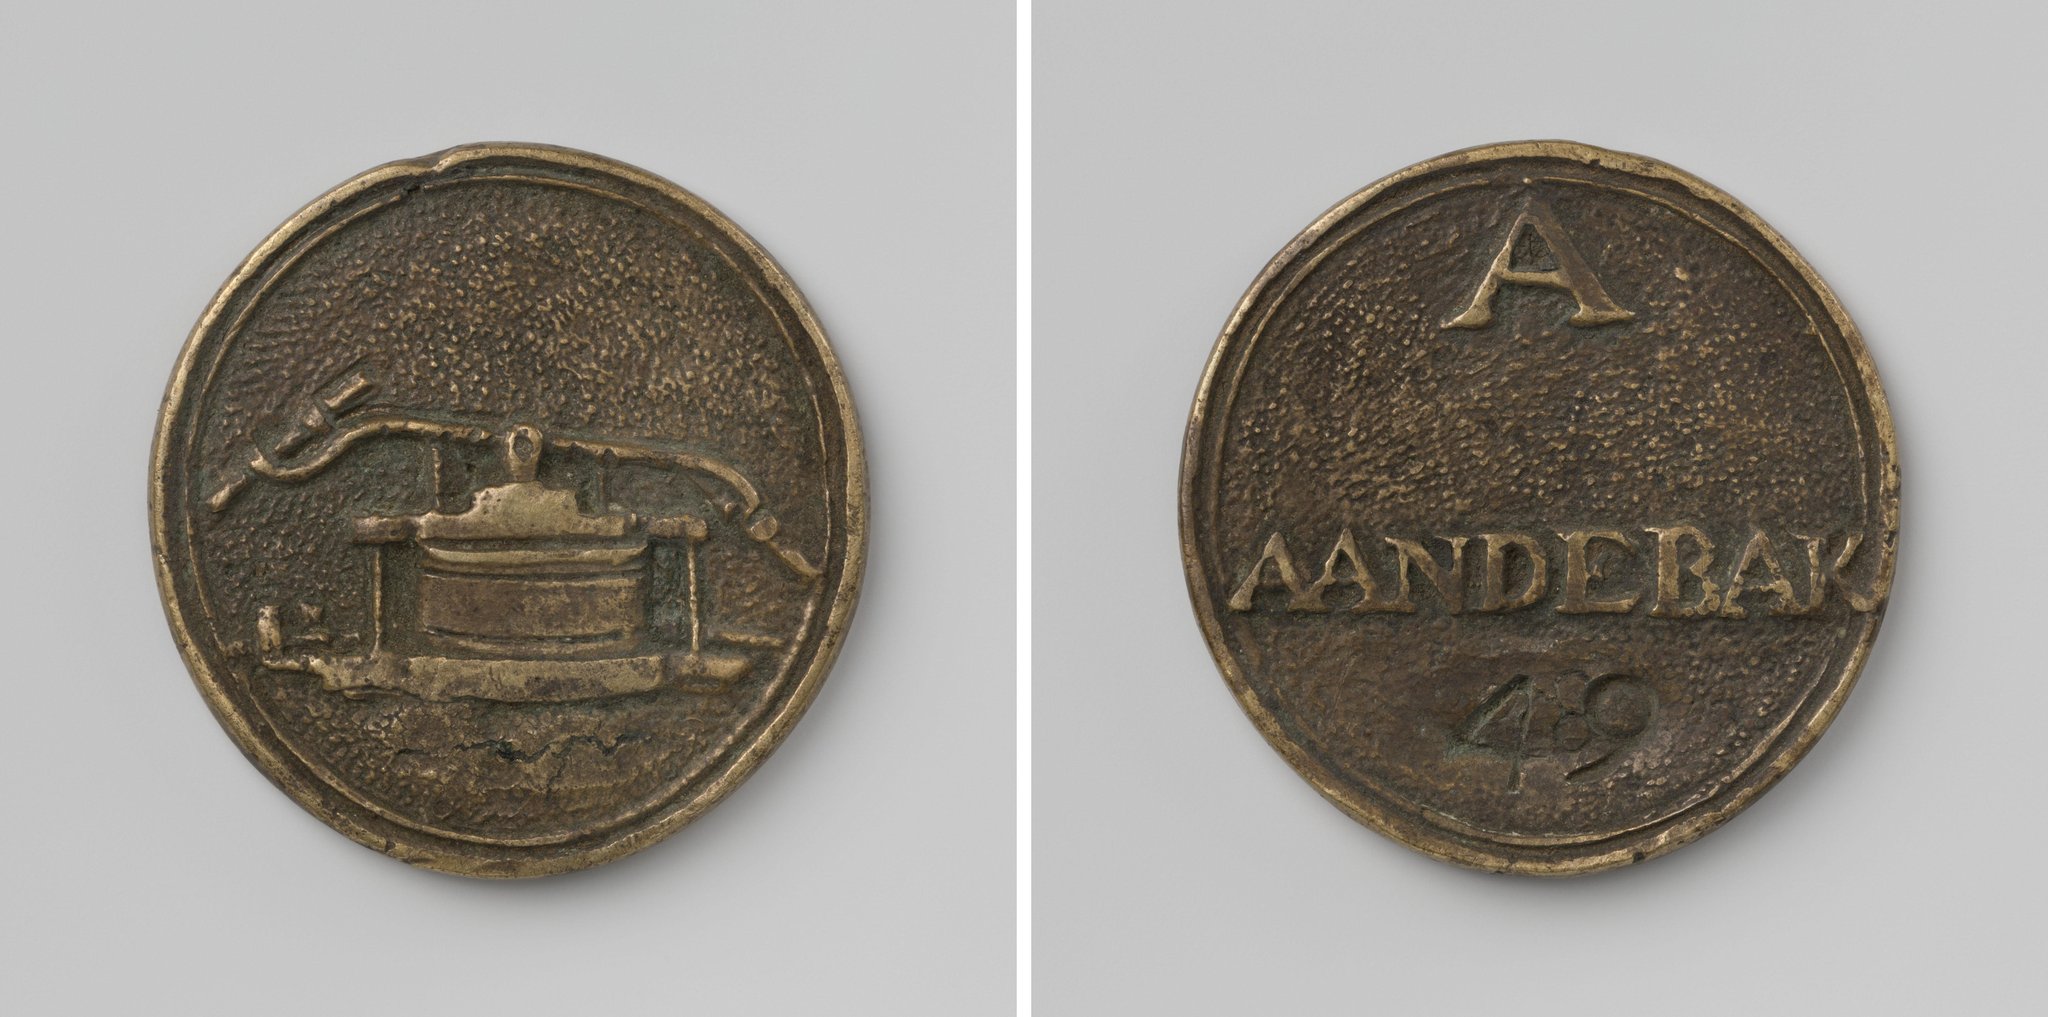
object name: medal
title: Enkhuizen, brandspuitpenning van de man aan de bak van spuit A met no. 49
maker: Anonymous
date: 1680-1800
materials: brass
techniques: casting, engraving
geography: enkhuizen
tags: enkhuizen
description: Messing penning. Voorzijde: brandspuit. Keerzijde: opschrift boven cijfer 49